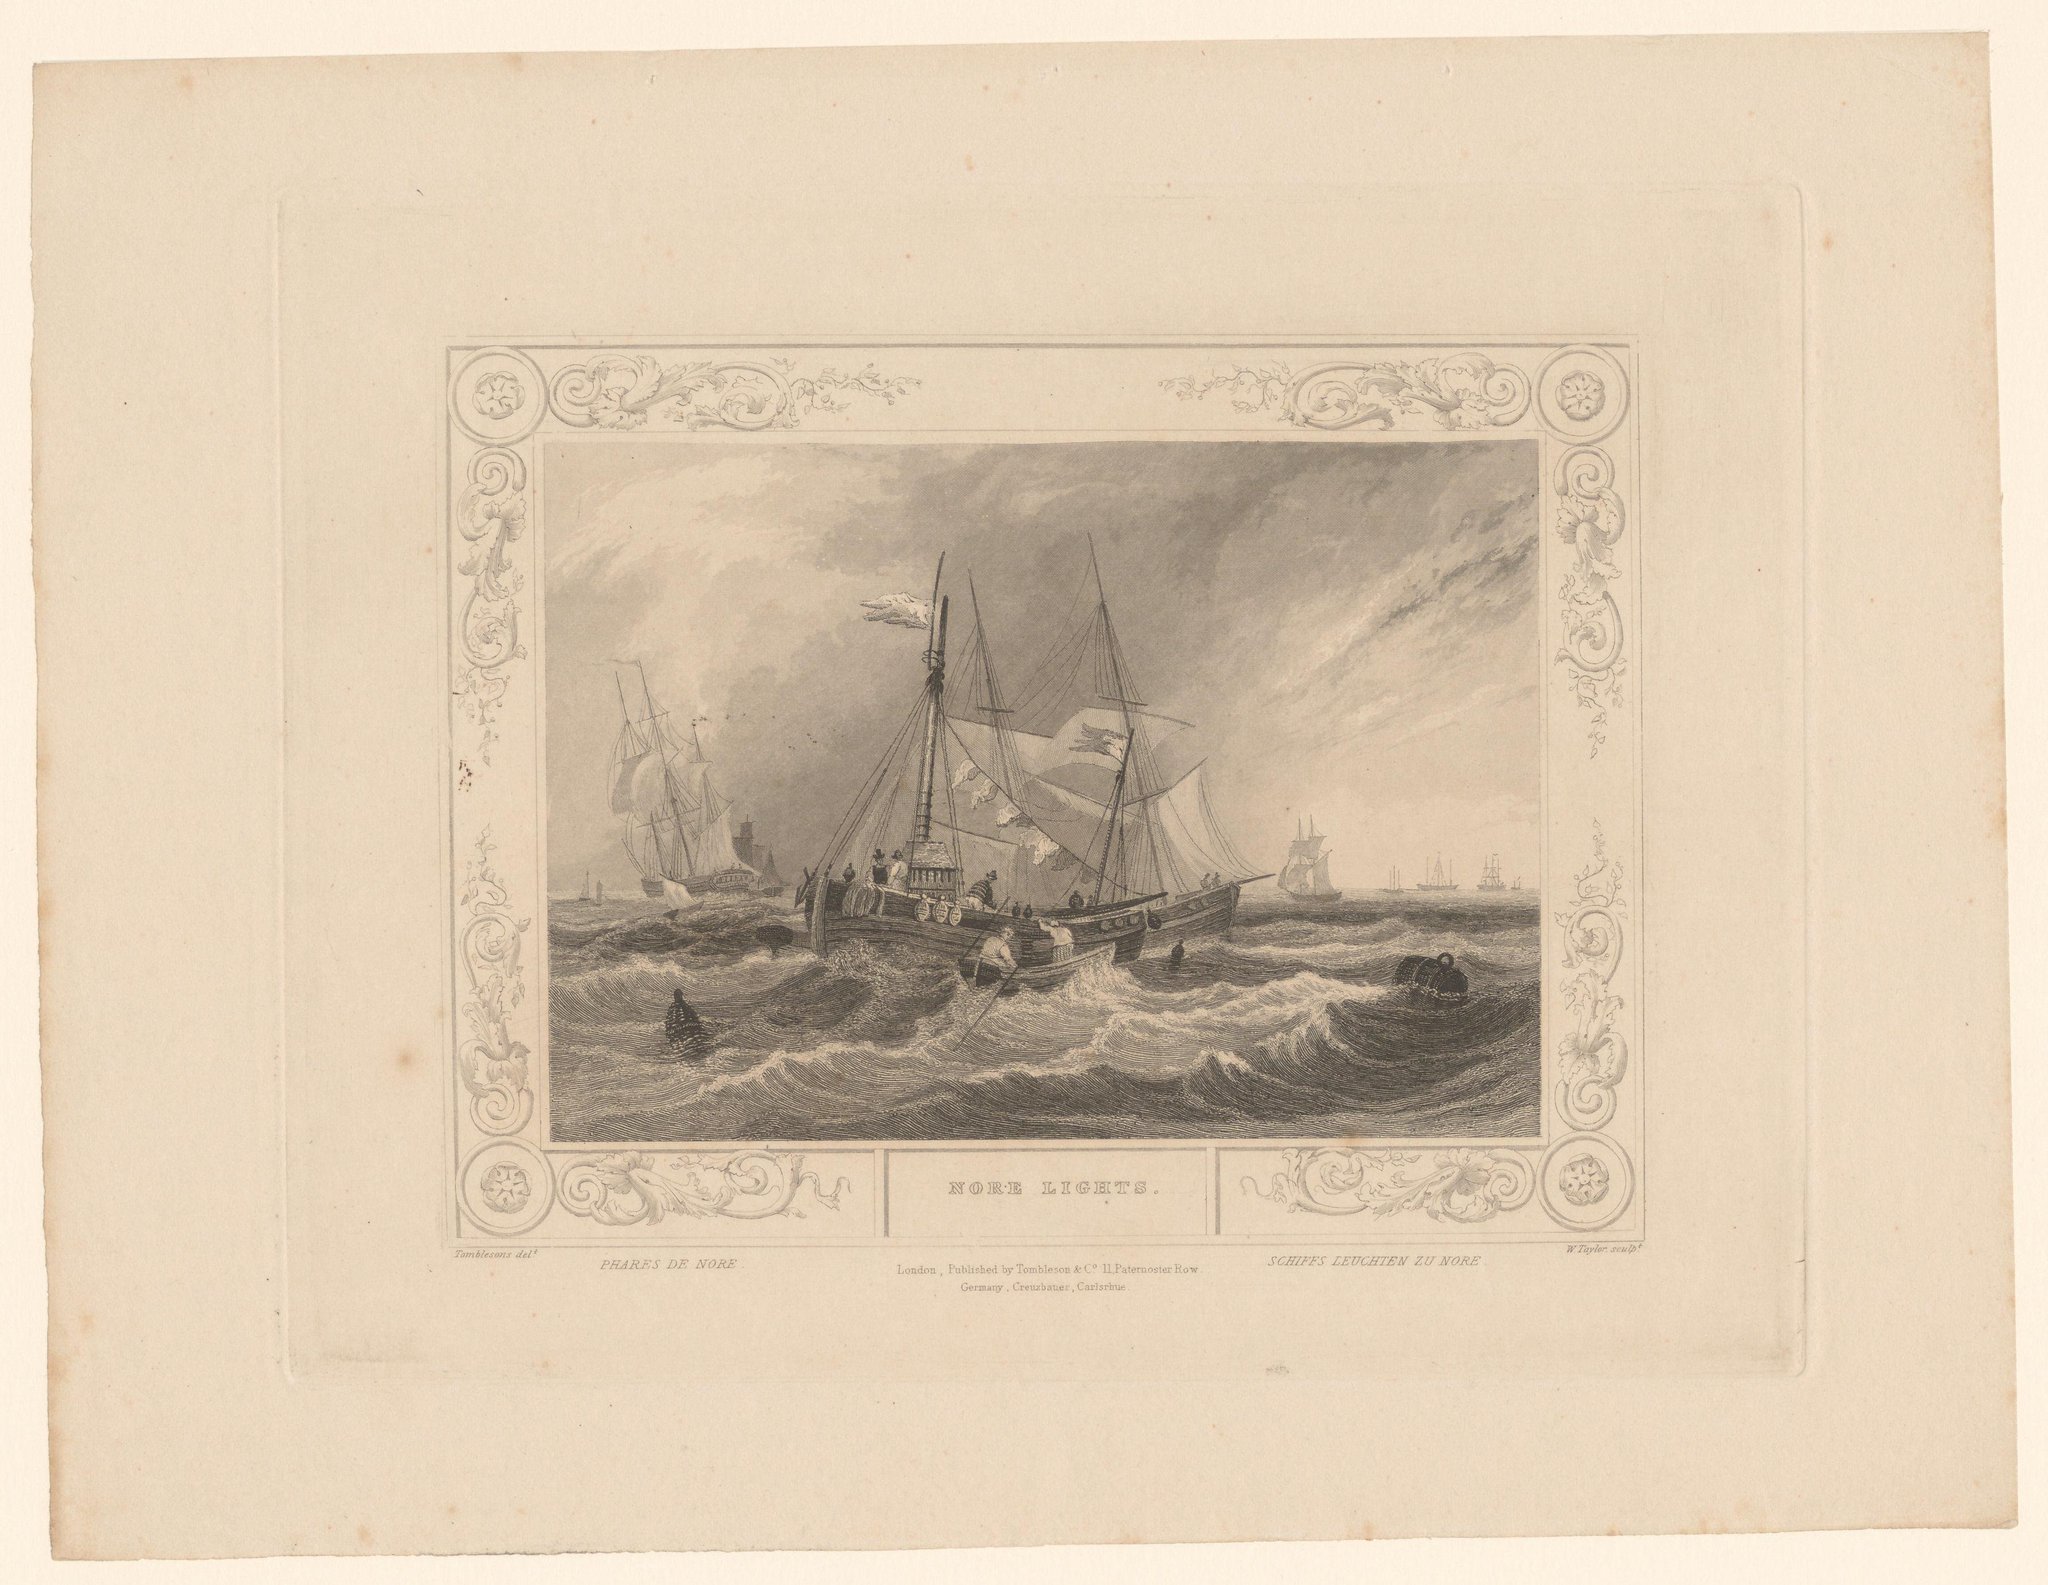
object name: book illustration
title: Zeilschepen op zee bij de Nore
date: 1831-1837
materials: paper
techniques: etching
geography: london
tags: sailing-ship, sailing-boat, sea (seascape)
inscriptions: collector's mark: Lugt 2228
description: Prent ook gebruikt in: Fearnside, W.G. Eighty Picturesque Views of the Thames and Medway (...). Londen: Black & Armstrong, [ca. 1831-1837].